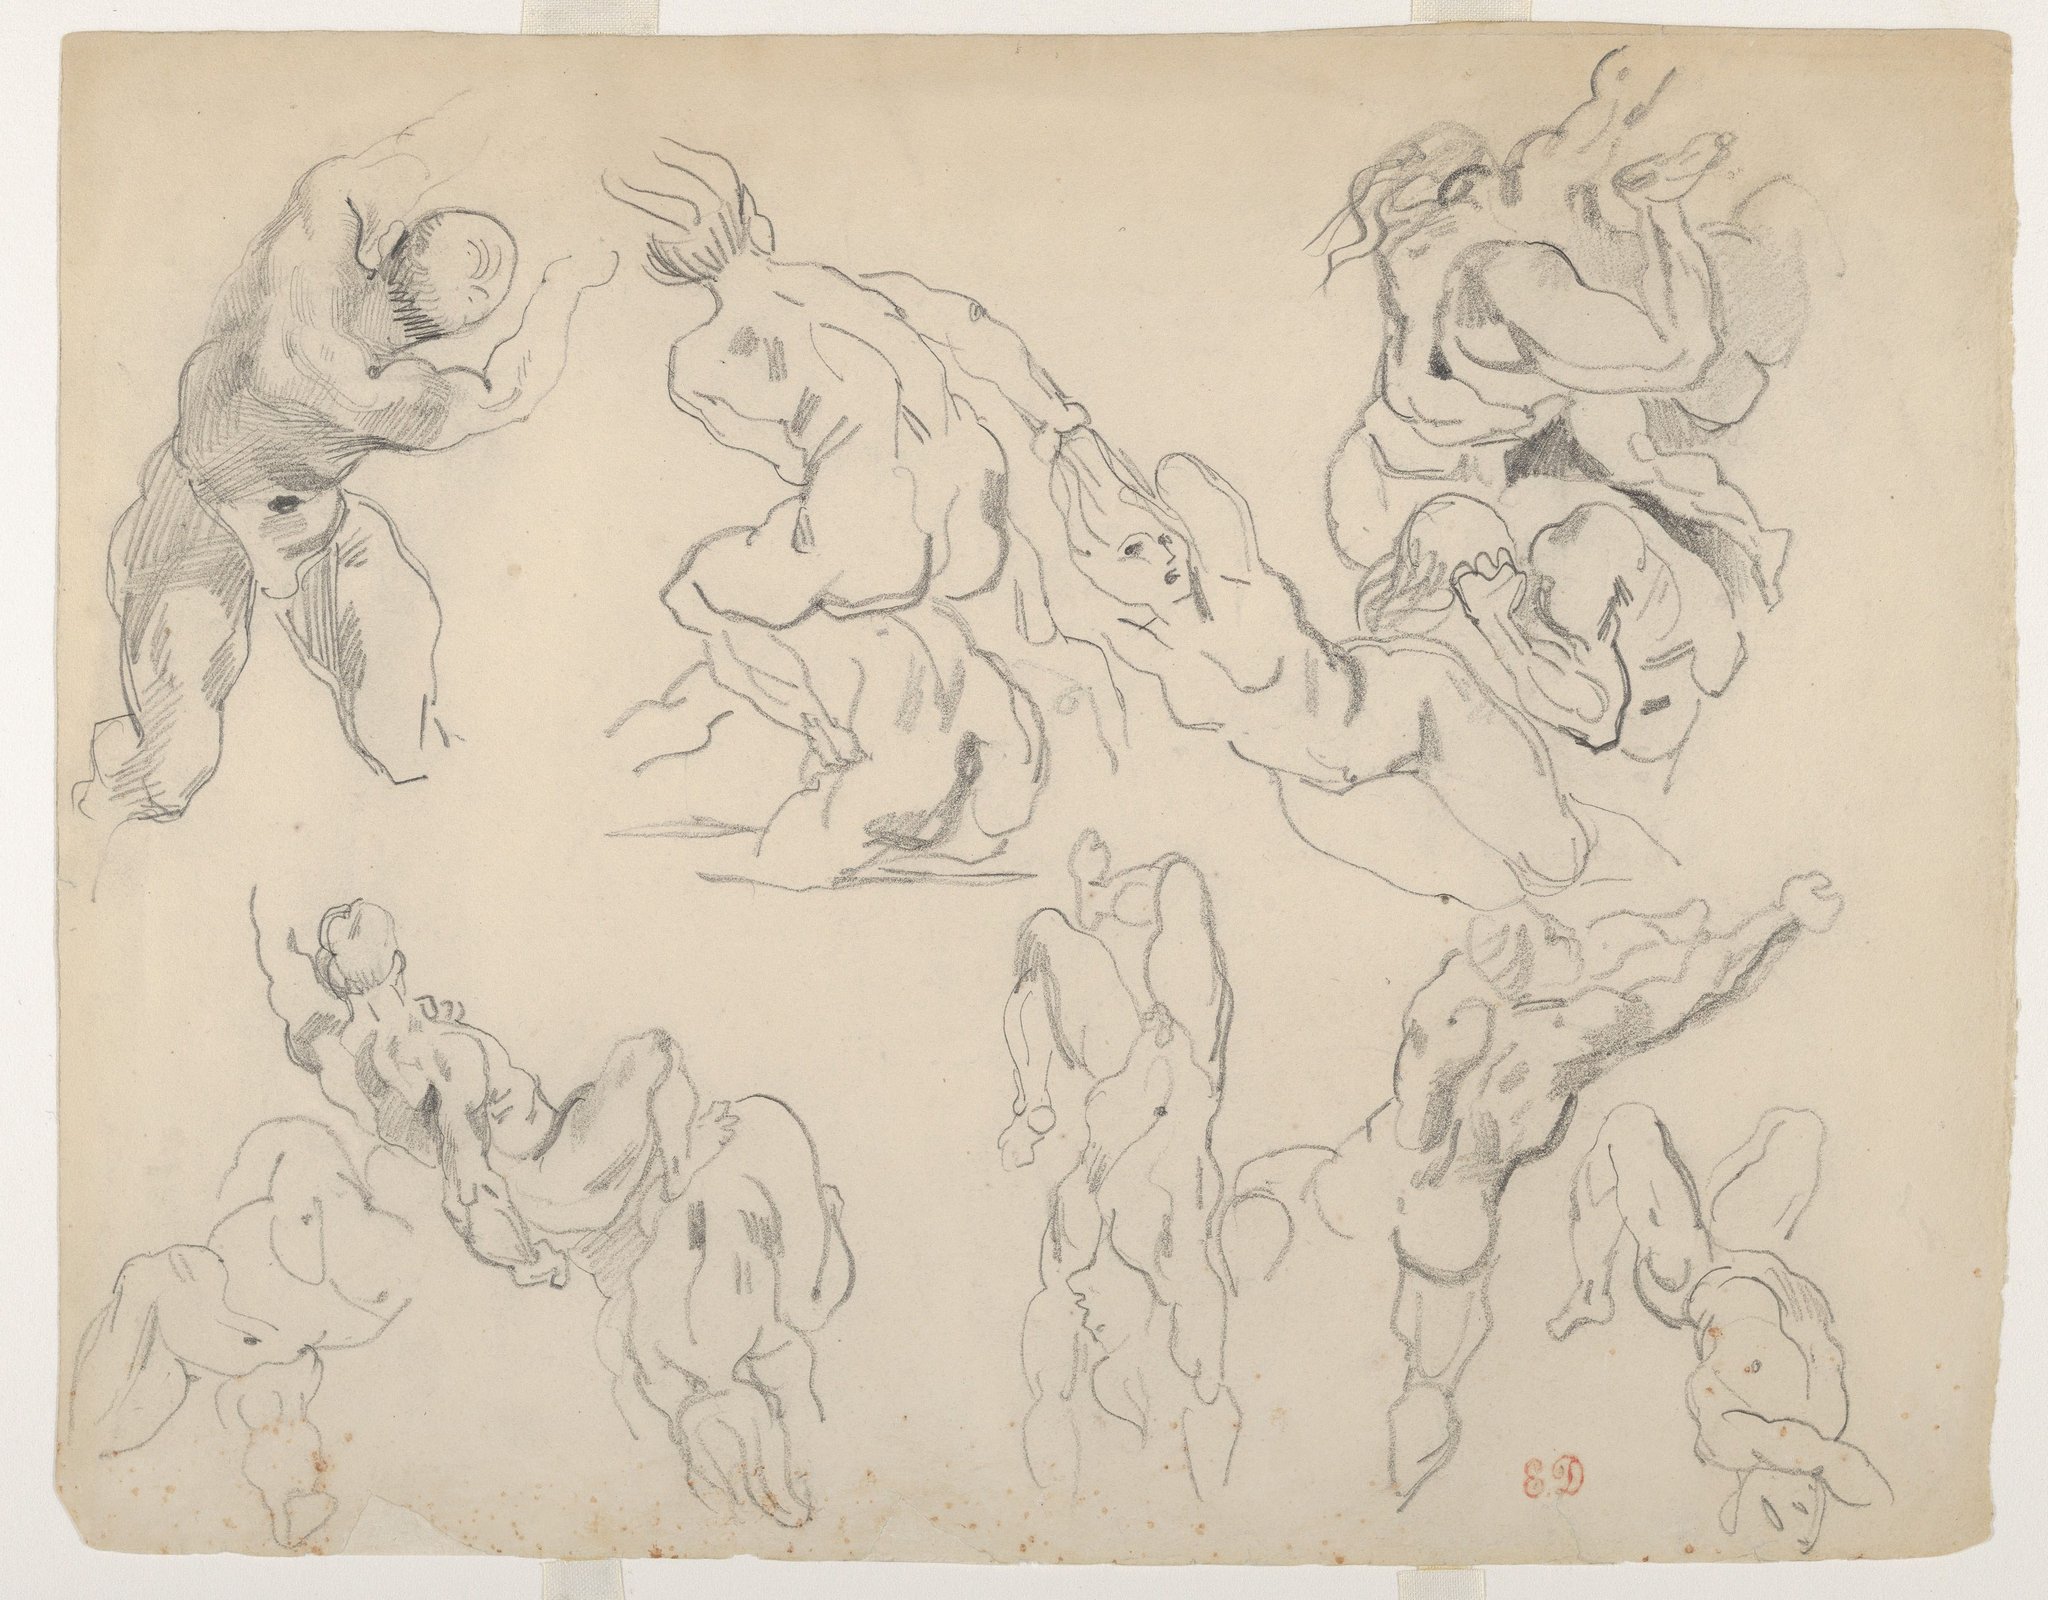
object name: drawing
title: Figure Studies after Rubens's "Fall of the Rebel Angels"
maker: eugène delacroix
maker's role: artist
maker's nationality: french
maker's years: 1798-1863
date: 1820-1822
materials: graphite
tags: male nudes,female nudes